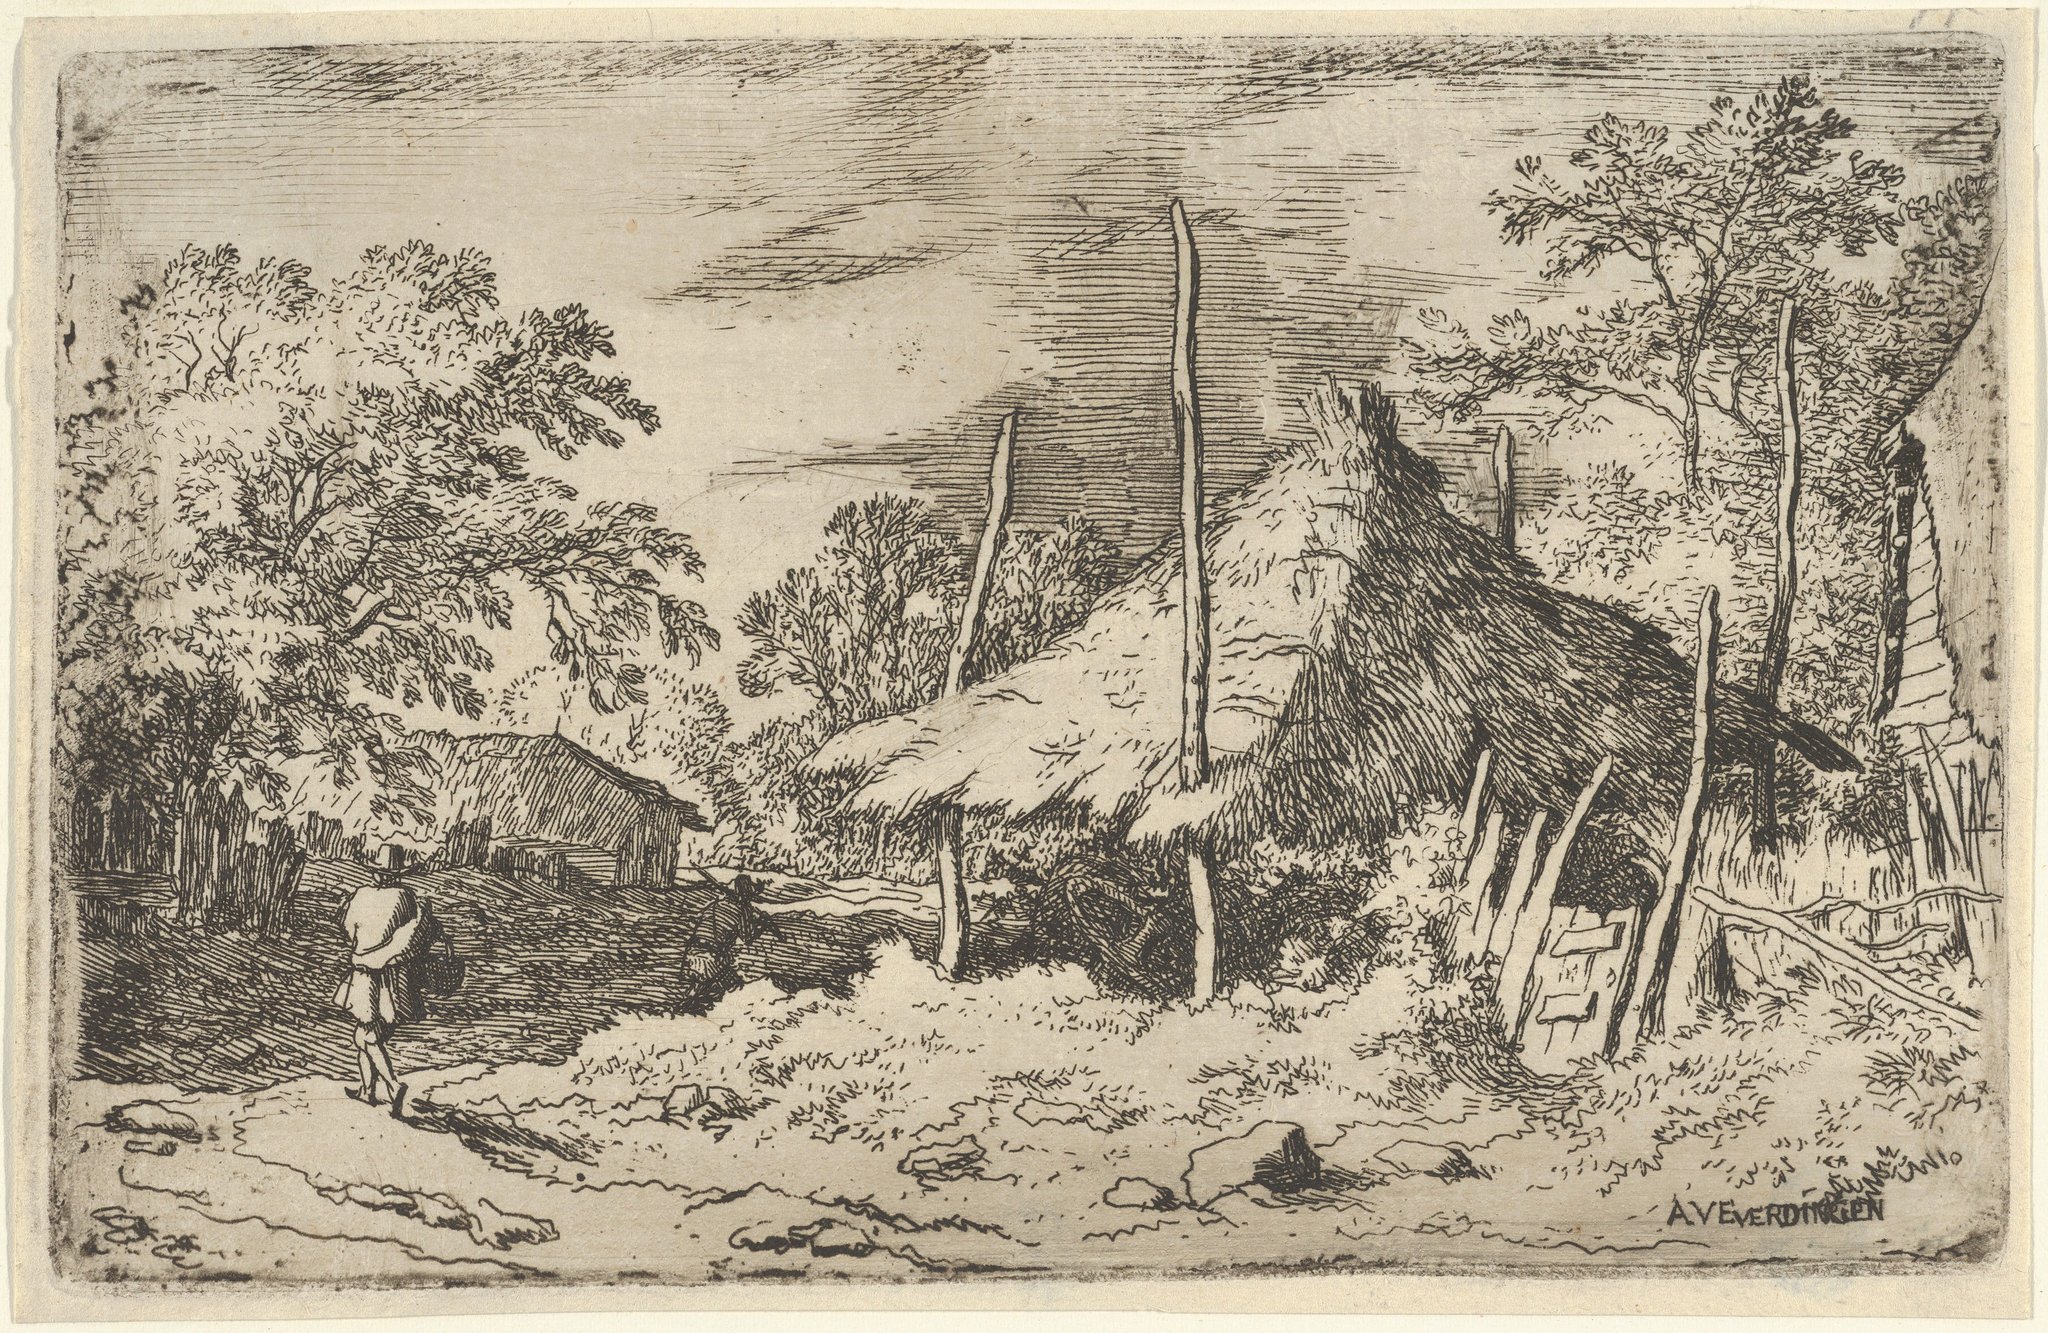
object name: print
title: The Wheel underneath the Haybarn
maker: allart van everdingen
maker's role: artist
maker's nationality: dutch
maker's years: 1621-1675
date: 1621-1675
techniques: engraving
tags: barns,landscapes